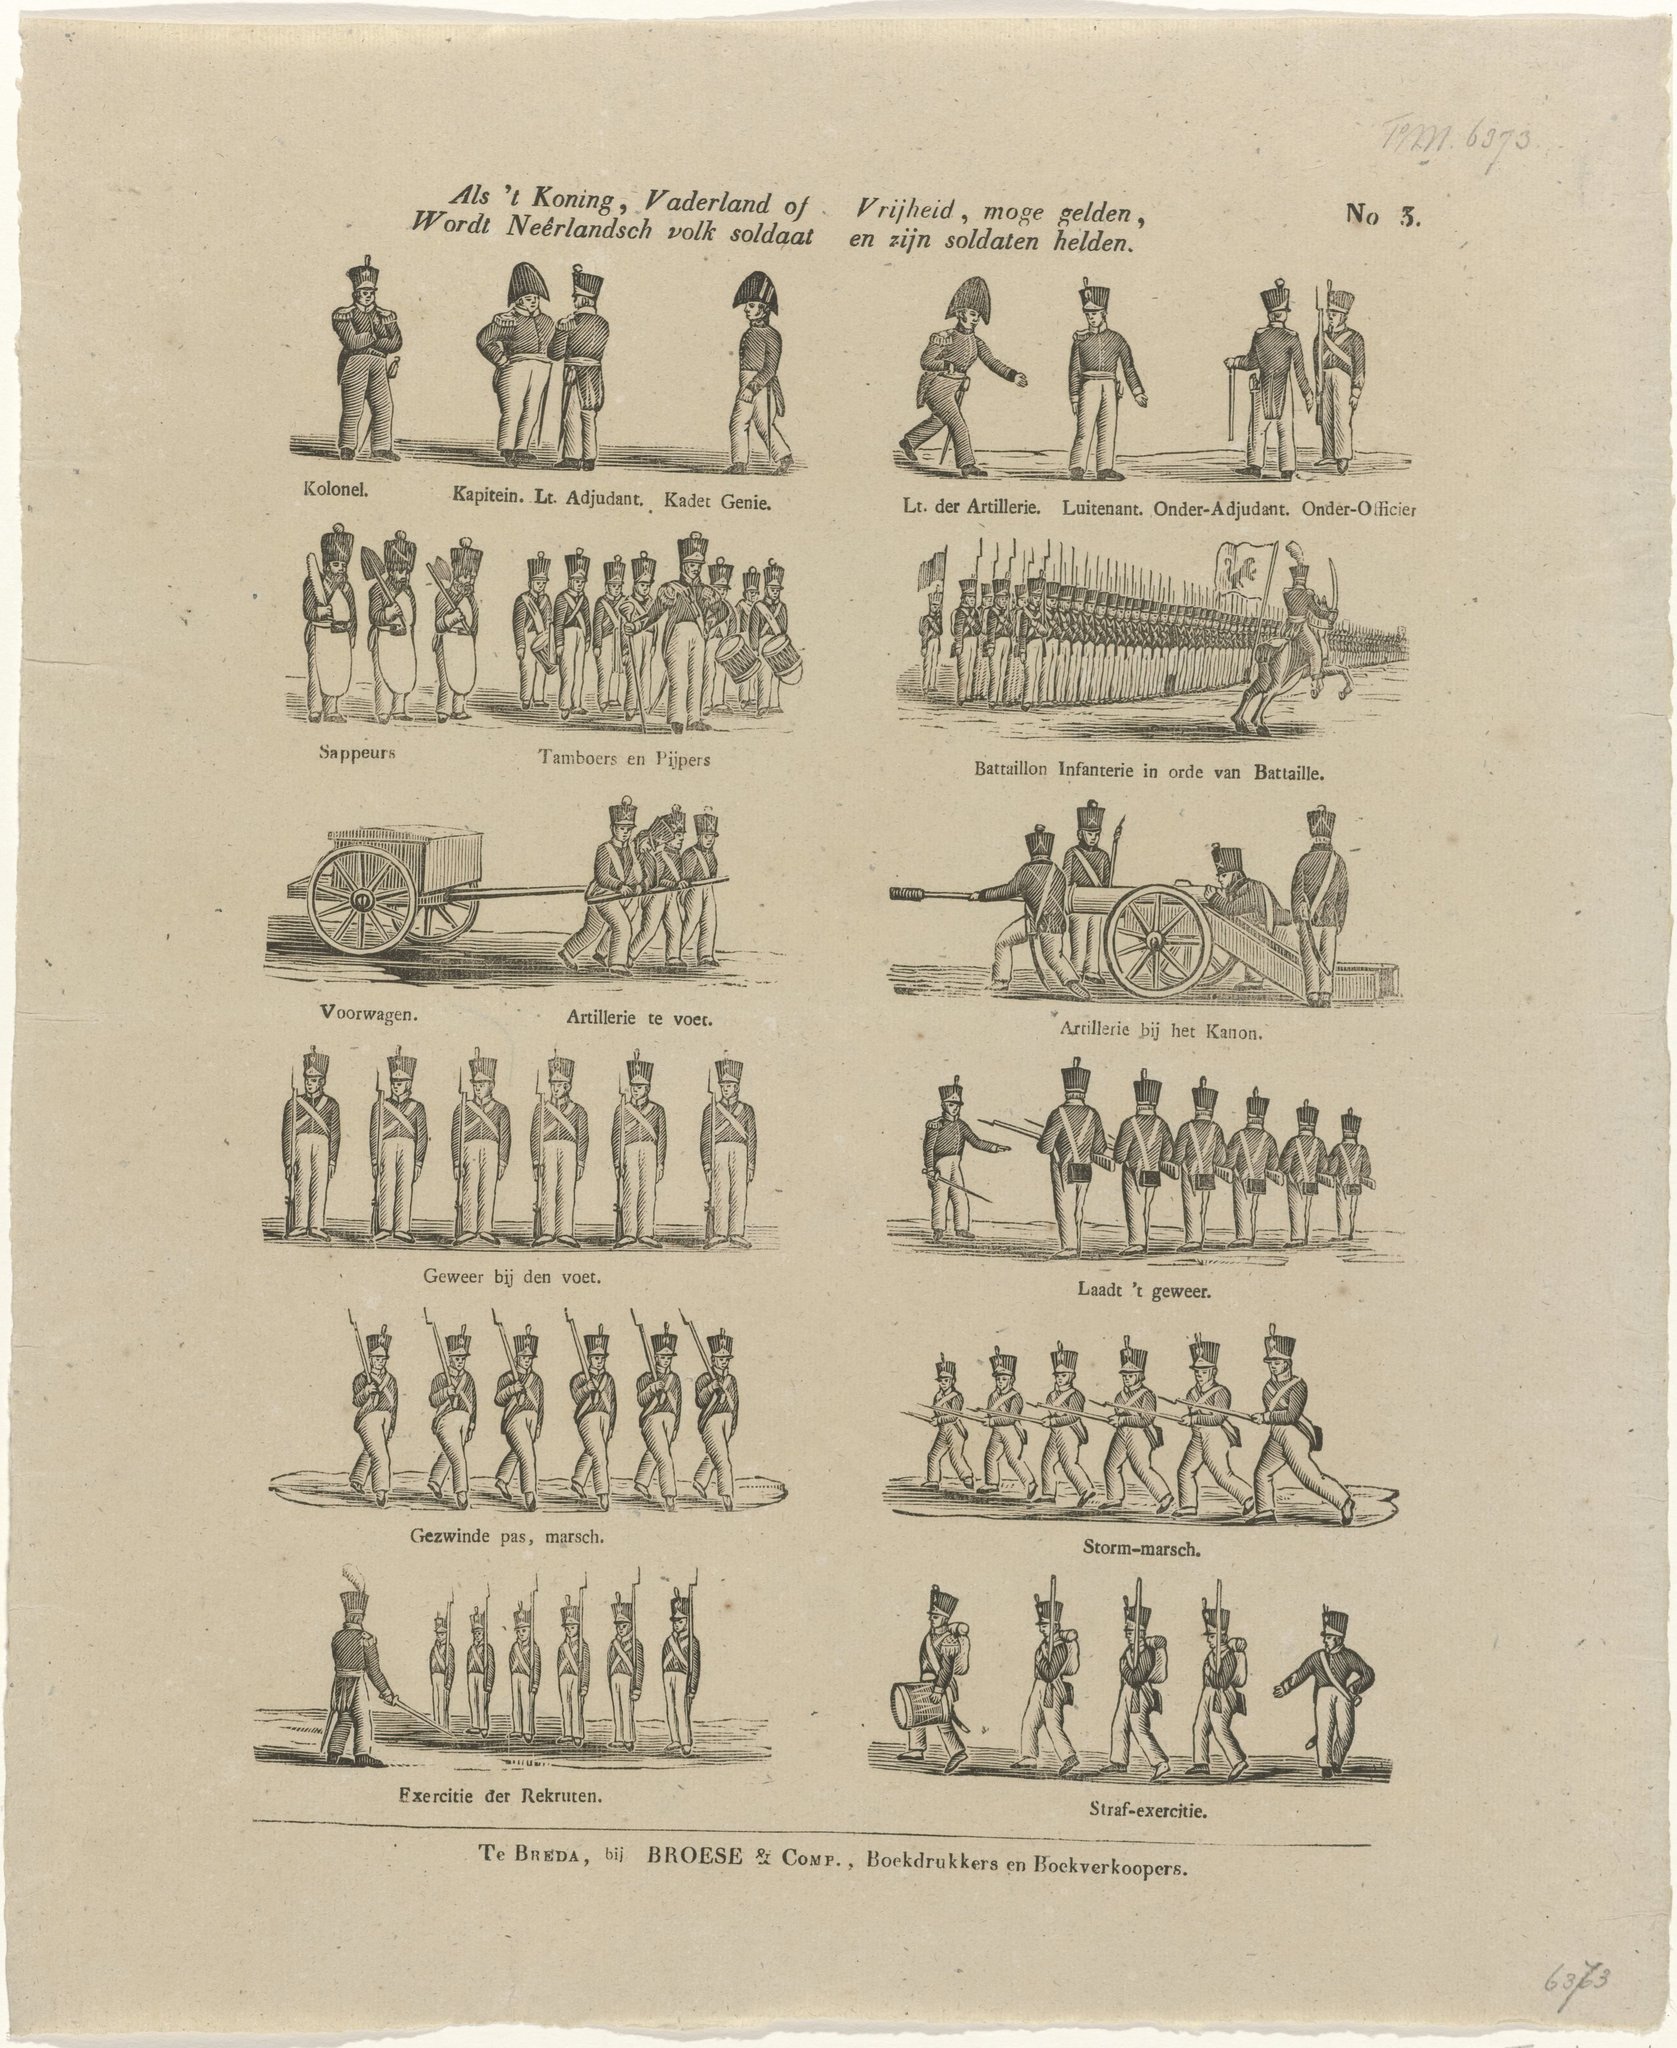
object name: popular print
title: Als 't Koning, Vaderland of Vrijheid, moge gelden, / Wordt Neêrlandsch volk soldaat en zijn soldaten helden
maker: Anonymous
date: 1830-1840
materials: paper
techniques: letterpress printing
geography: netherlands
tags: drill ~ military training, warfare; military affairs (+ land forces)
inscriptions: collector's mark: Lugt 2228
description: Blad met twaalf voorstellingen van Nederlandse militairen, rangen en exercities, ca. 1830-1831. Waarschijnlijk gerelateerd aan de Belgische Revoluitie. Onder elk plaatje een onderschrift. Genummerd rechtsboven: No. 3.